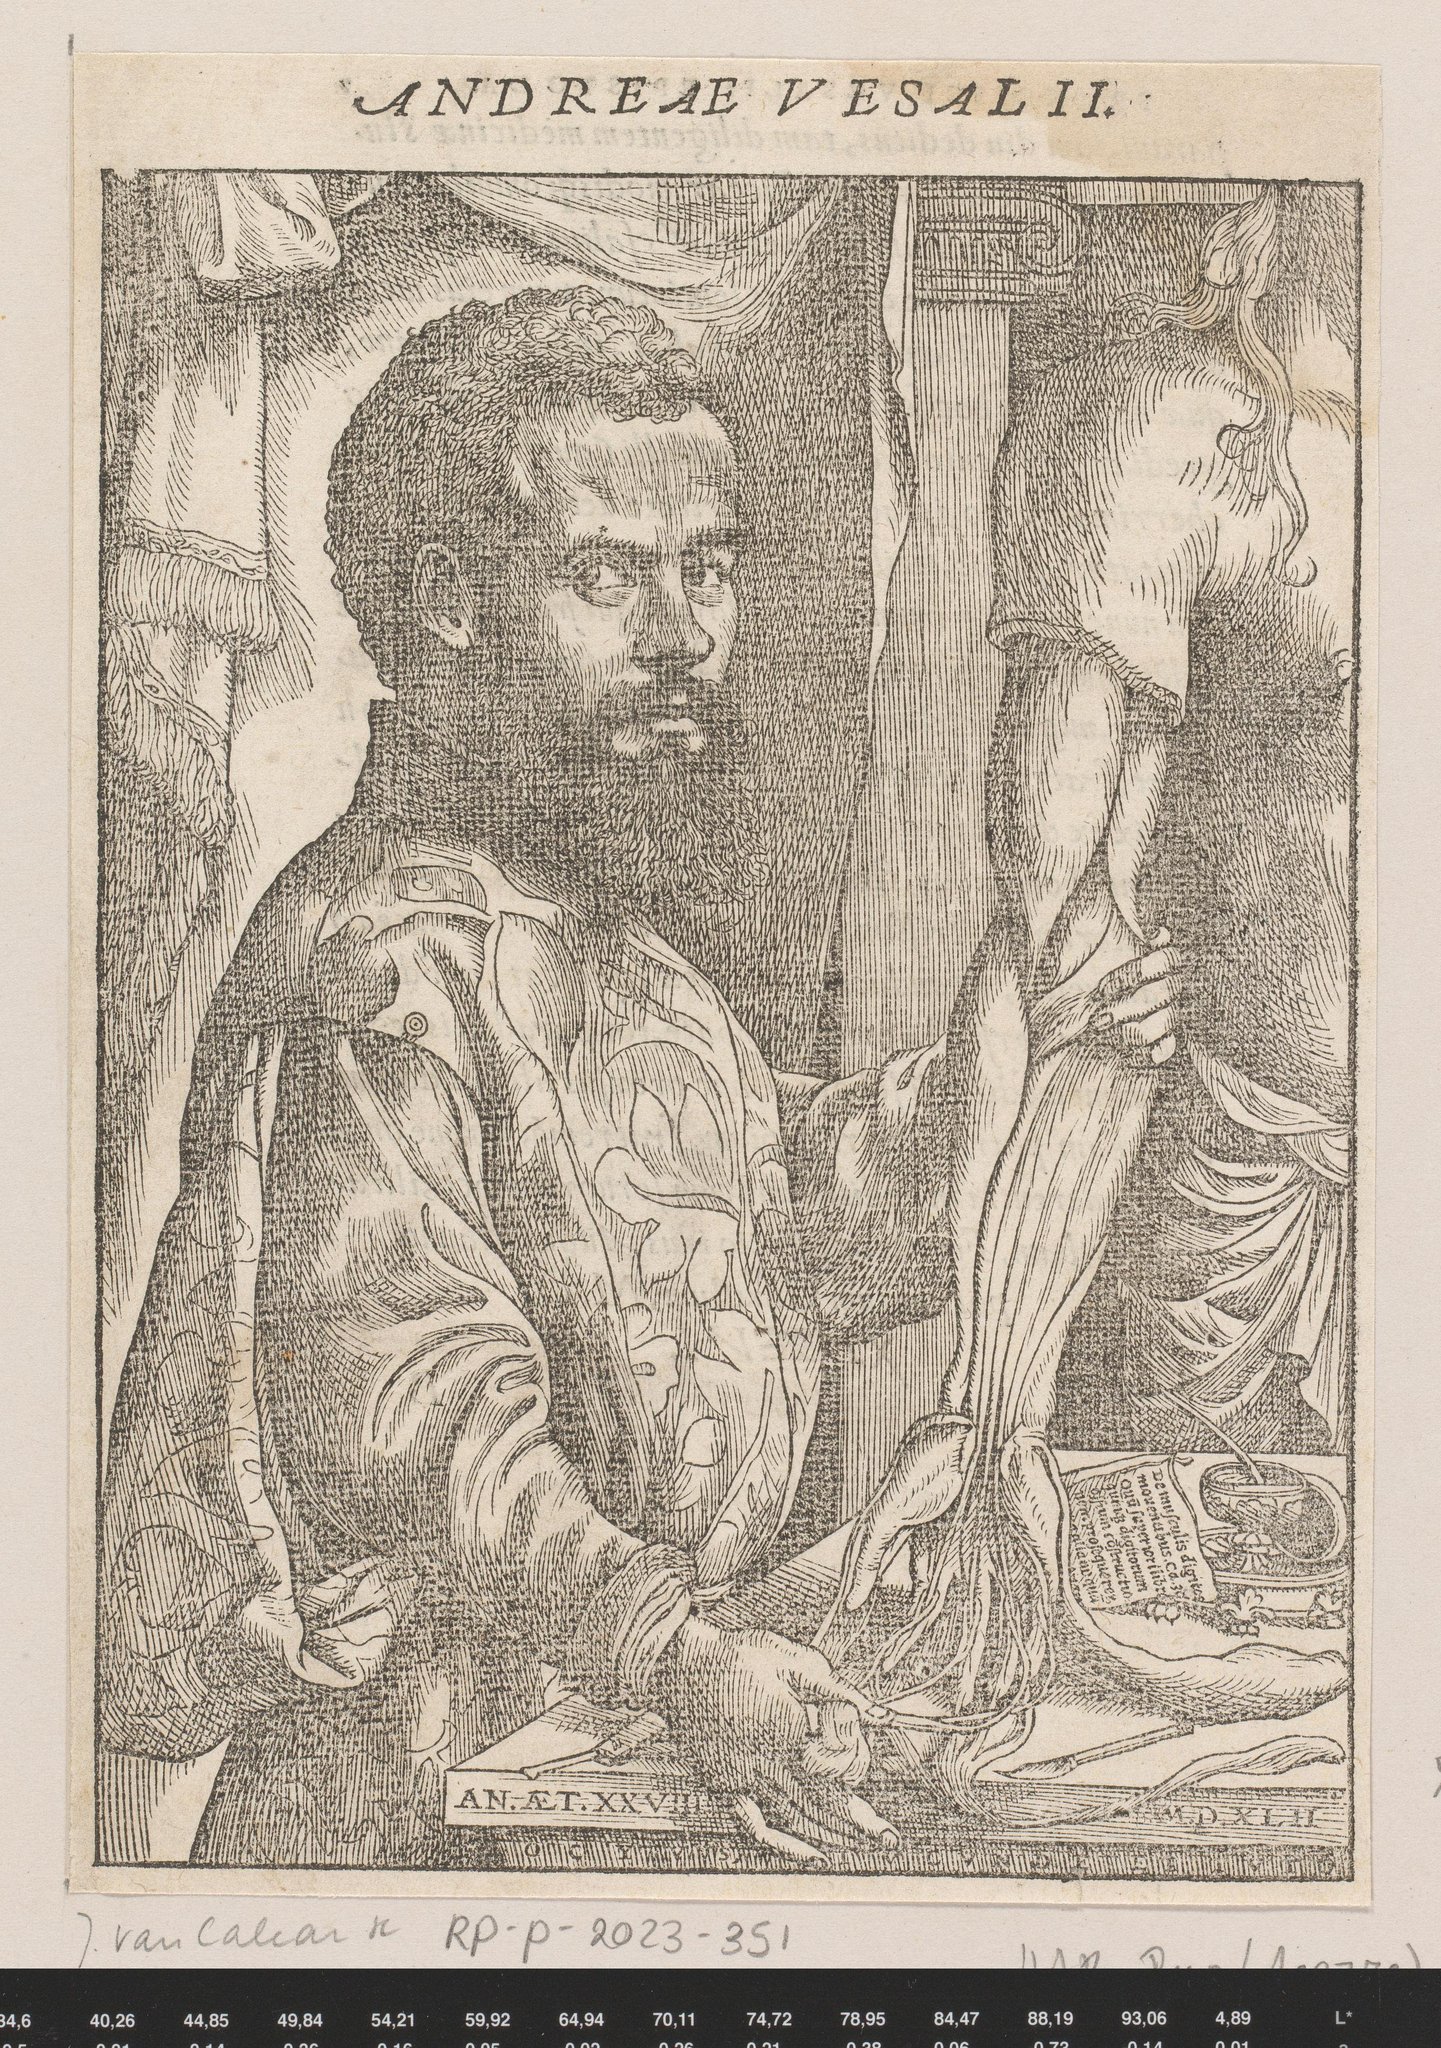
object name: print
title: Portret van Andreas Vesalius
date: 1546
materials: paper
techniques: letterpress printing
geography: italy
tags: brussels, historical persons, physician, doctor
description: Prent uit: Versalius, Andreas. Andreae Vesalij Bruxellensis (...). Bazel: Jan Herpst, 1546.